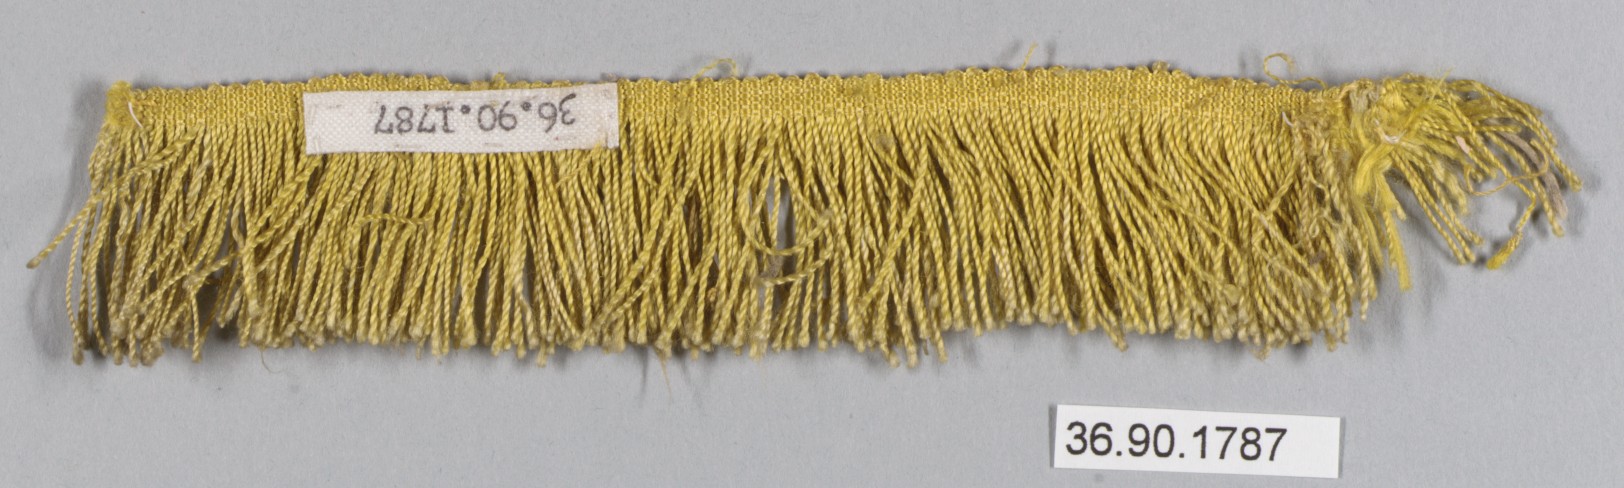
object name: fringe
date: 1750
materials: silk